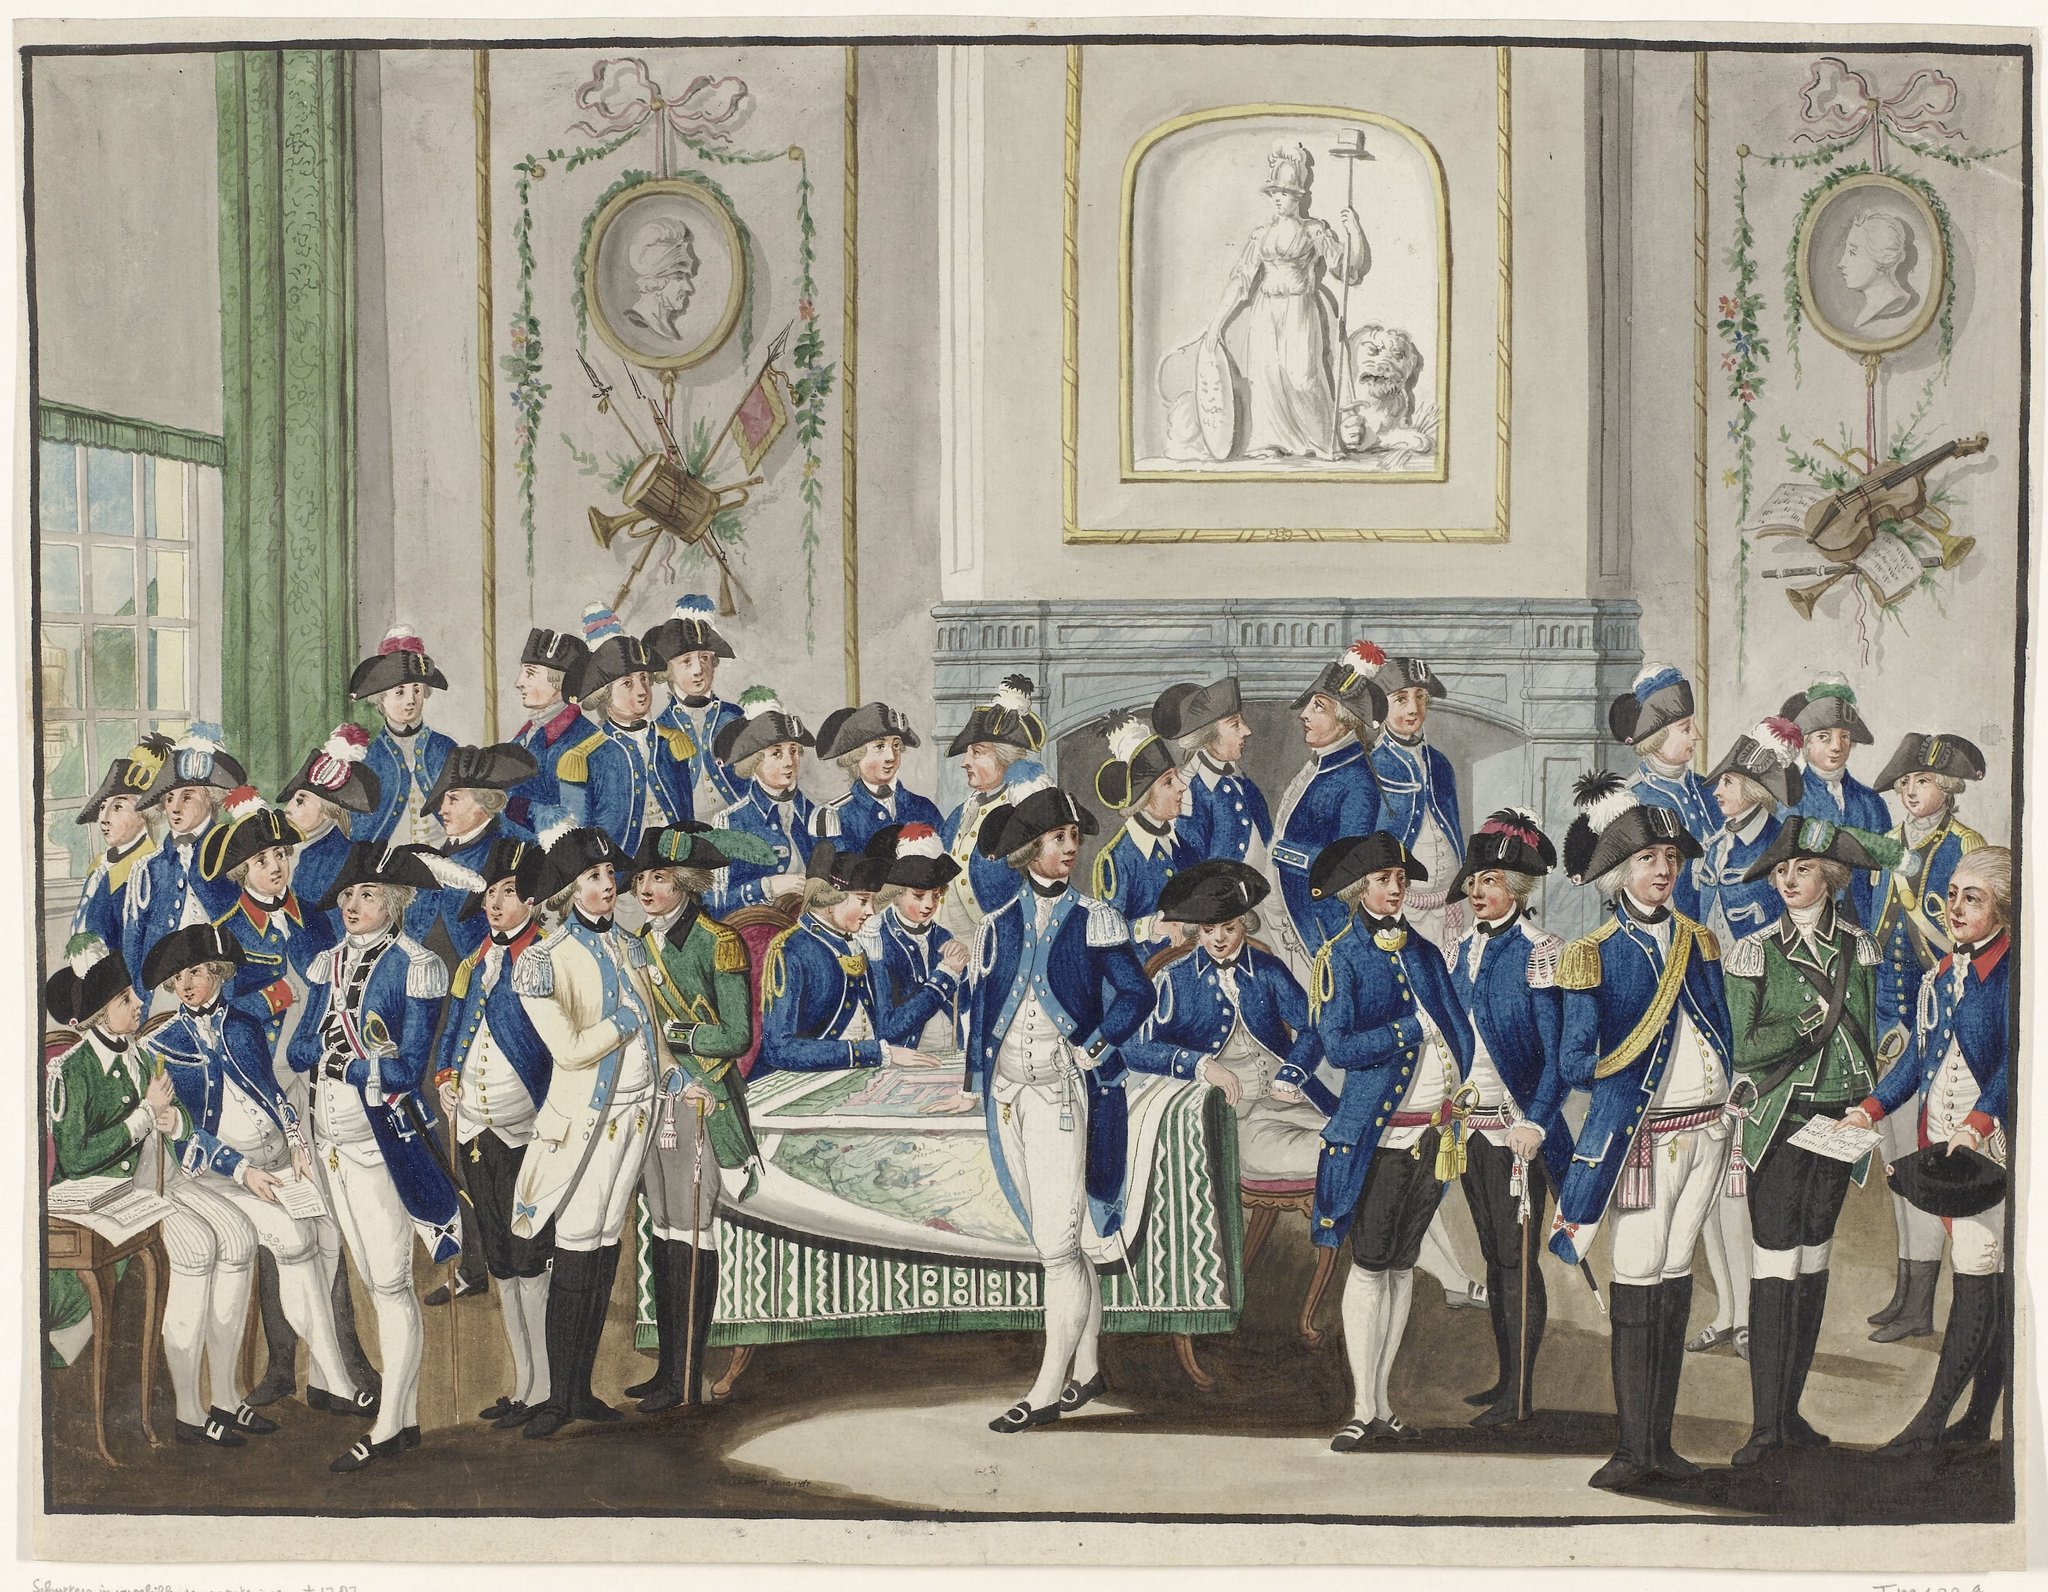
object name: costume print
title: Zaal met schutters in verschillende monteringen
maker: christiaan van waardt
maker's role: painter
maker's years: 1761-1820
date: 1787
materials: paper, watercolor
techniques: brush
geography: northern netherlands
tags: (military) uniforms (+ citizen soldiery, civil guard, citizen militia), patriots (1780-1795)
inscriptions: signature: ‘C. van Waardt Fecit’, collector's mark: Lugt 2228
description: Zaal met 35 schutters in de verschillende monteringen (uniformen) van schutterijen en burgerkorpsen in Nederland in 1787. Op een tafel liggen kaarten die worden bestudeerd. Tegen de achterwand schilderingen van staande Vrijheid, links een kop met trofee van wapens, rechts een kop met een trofee van muziekinstrumenten.